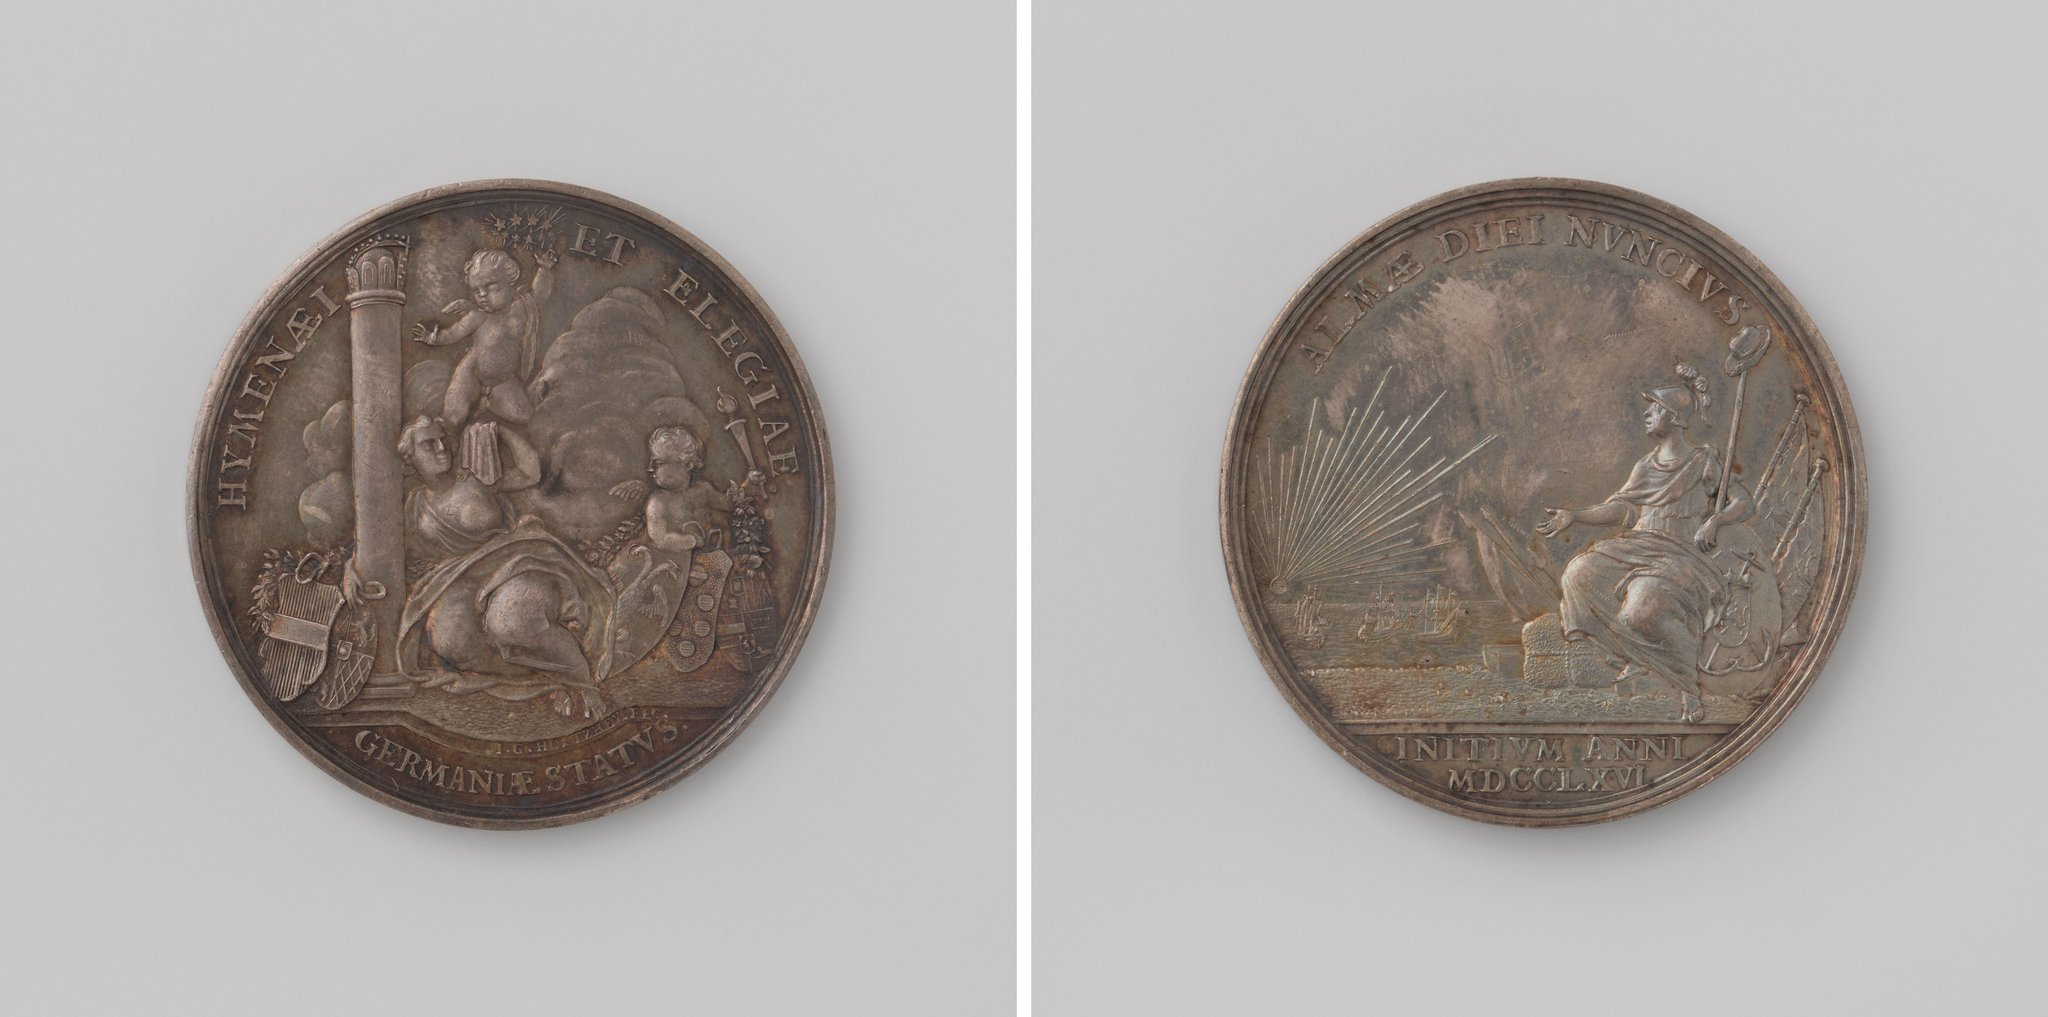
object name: new year medal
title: Aanvang van het jaar 1766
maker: johan george holtzhey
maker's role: mintmaster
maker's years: 1726-1808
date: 1766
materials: silver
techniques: striking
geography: amsterdam